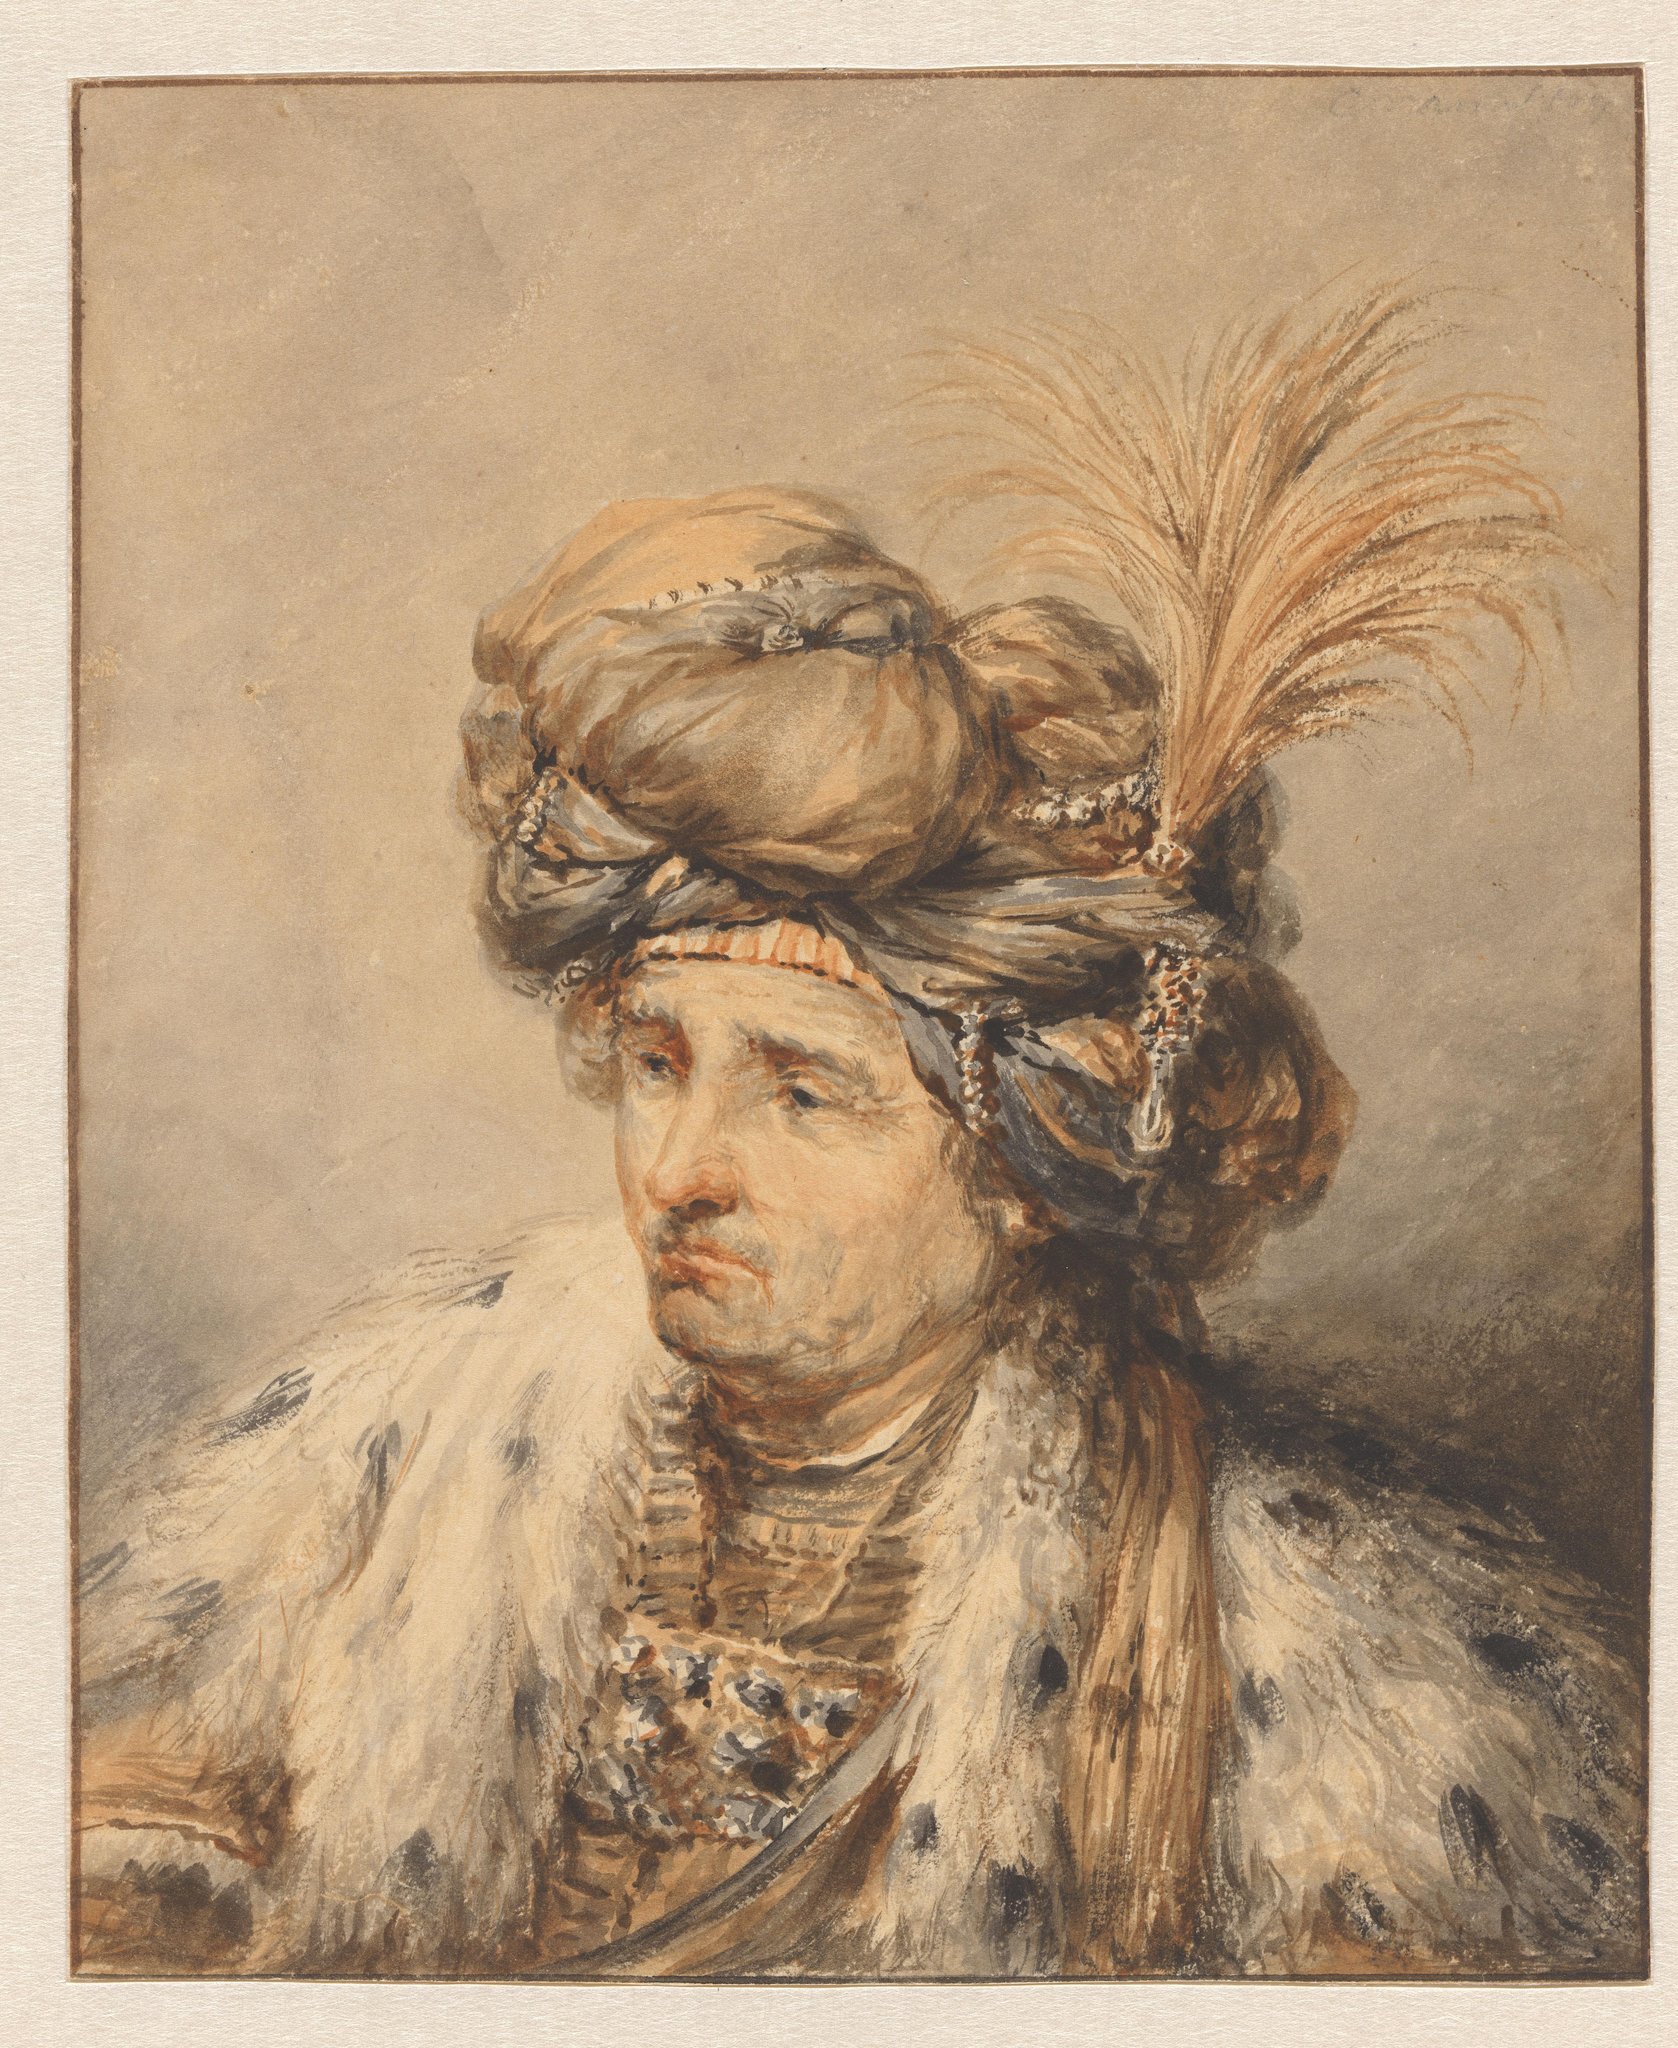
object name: drawing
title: Portrait of a Man Wearing a Turban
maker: abraham van strij (i)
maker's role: draughtsman, painter, print maker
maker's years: 1753-1826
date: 1800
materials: chalk, paint, paper, watercolor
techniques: aquarelle, drawing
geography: dordrecht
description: Tronie van een man in een fantasierijk kostuum met een met juwelen en veren versierde tulband.